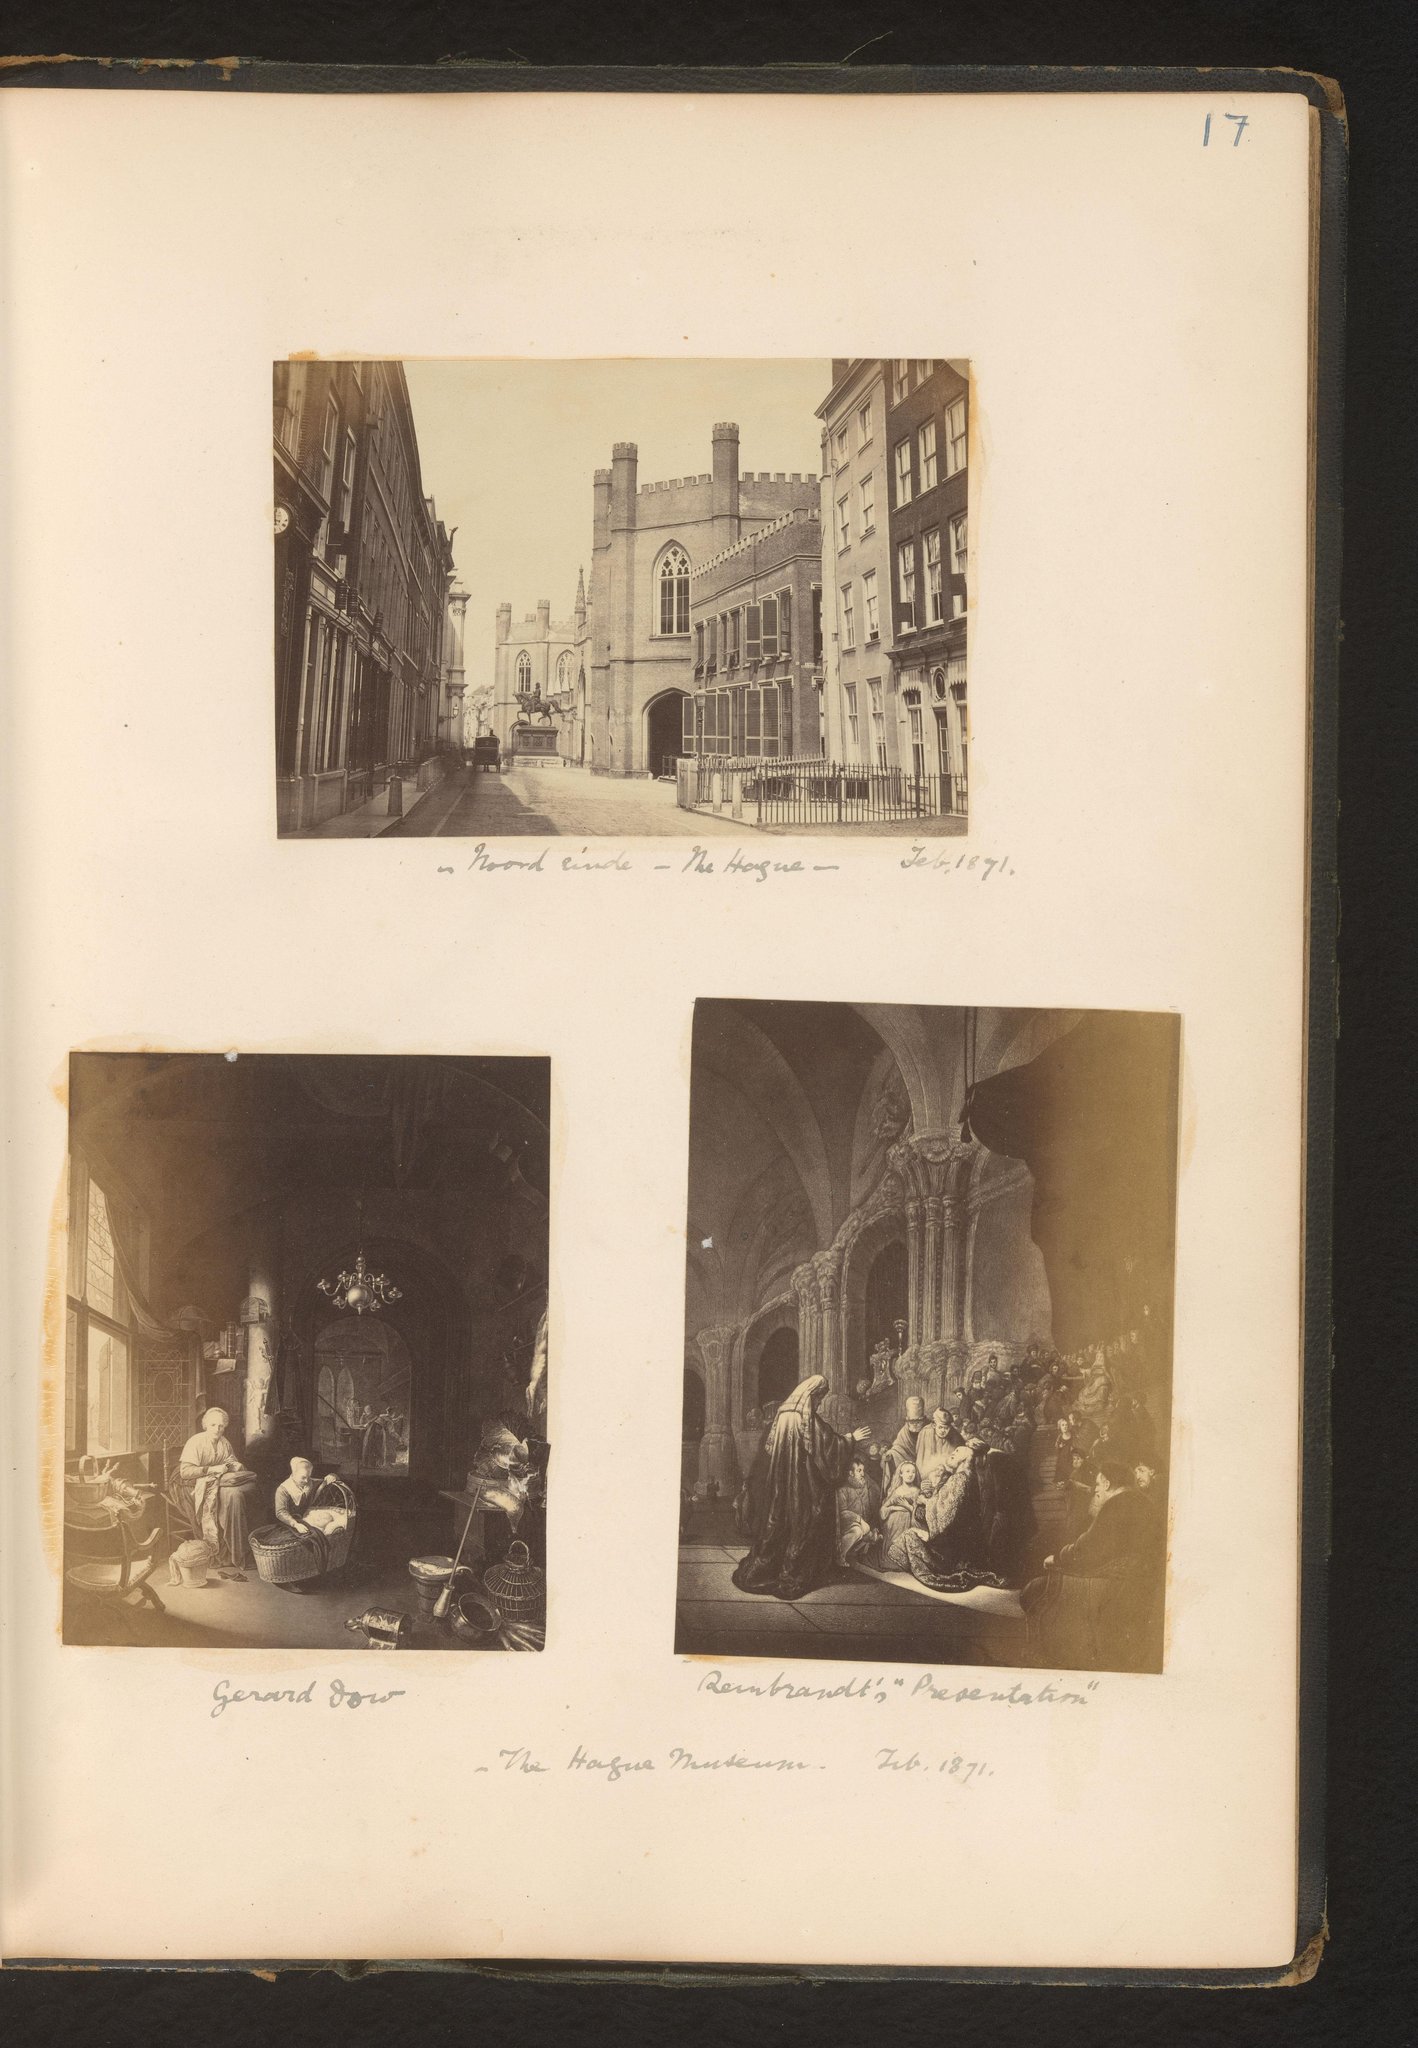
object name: album leaf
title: Noordeinde te Den Haag en twee fotoreproducties van schilderijen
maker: Anonymous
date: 1802-1871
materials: paper, photographic support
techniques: albumen print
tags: art collection, art gallery, picture, painting, street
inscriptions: annotation: ‘Gerard Dou/ Rembrandt's "Presentation"/ - The Hague Museum.’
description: Fotoreproducties van De jonge moeder van Gerard Dou en Het loflied van Simeon door Rembrandt van Rijn. Deze pagina maakt deel uit van een album.